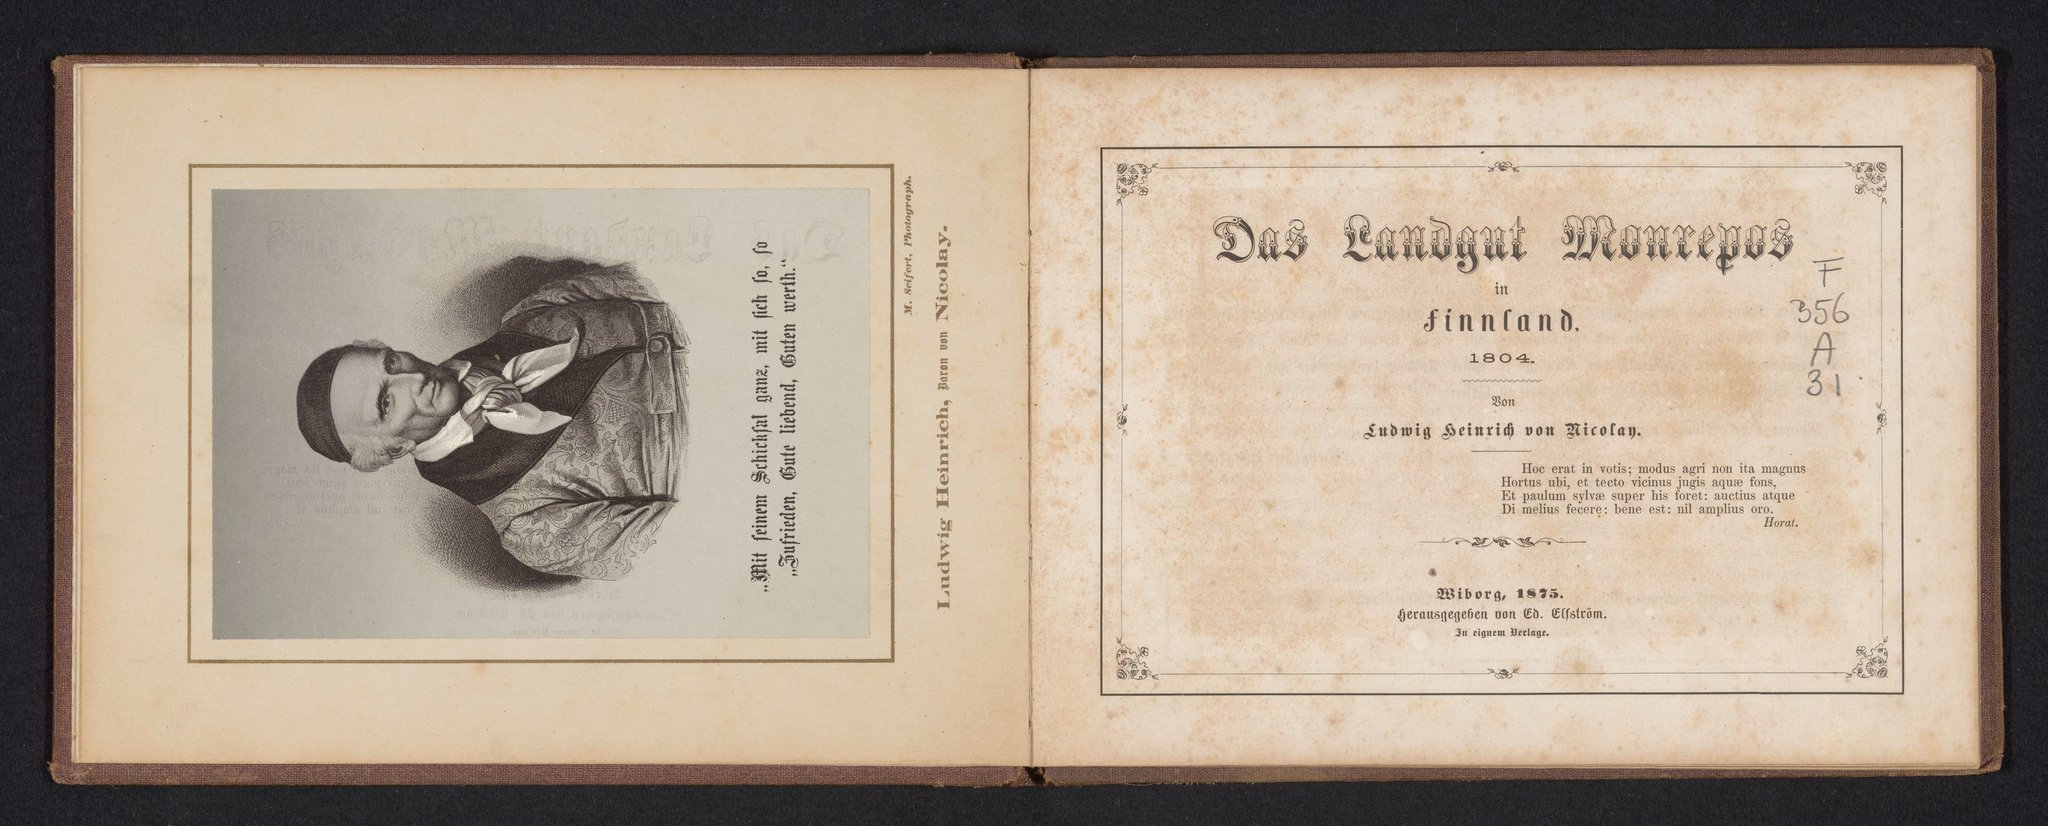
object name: book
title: Das Landgut Monrepos in Finnland 1804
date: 1875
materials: cardboard, linen, paper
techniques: decorated paper, photolithography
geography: vyborg